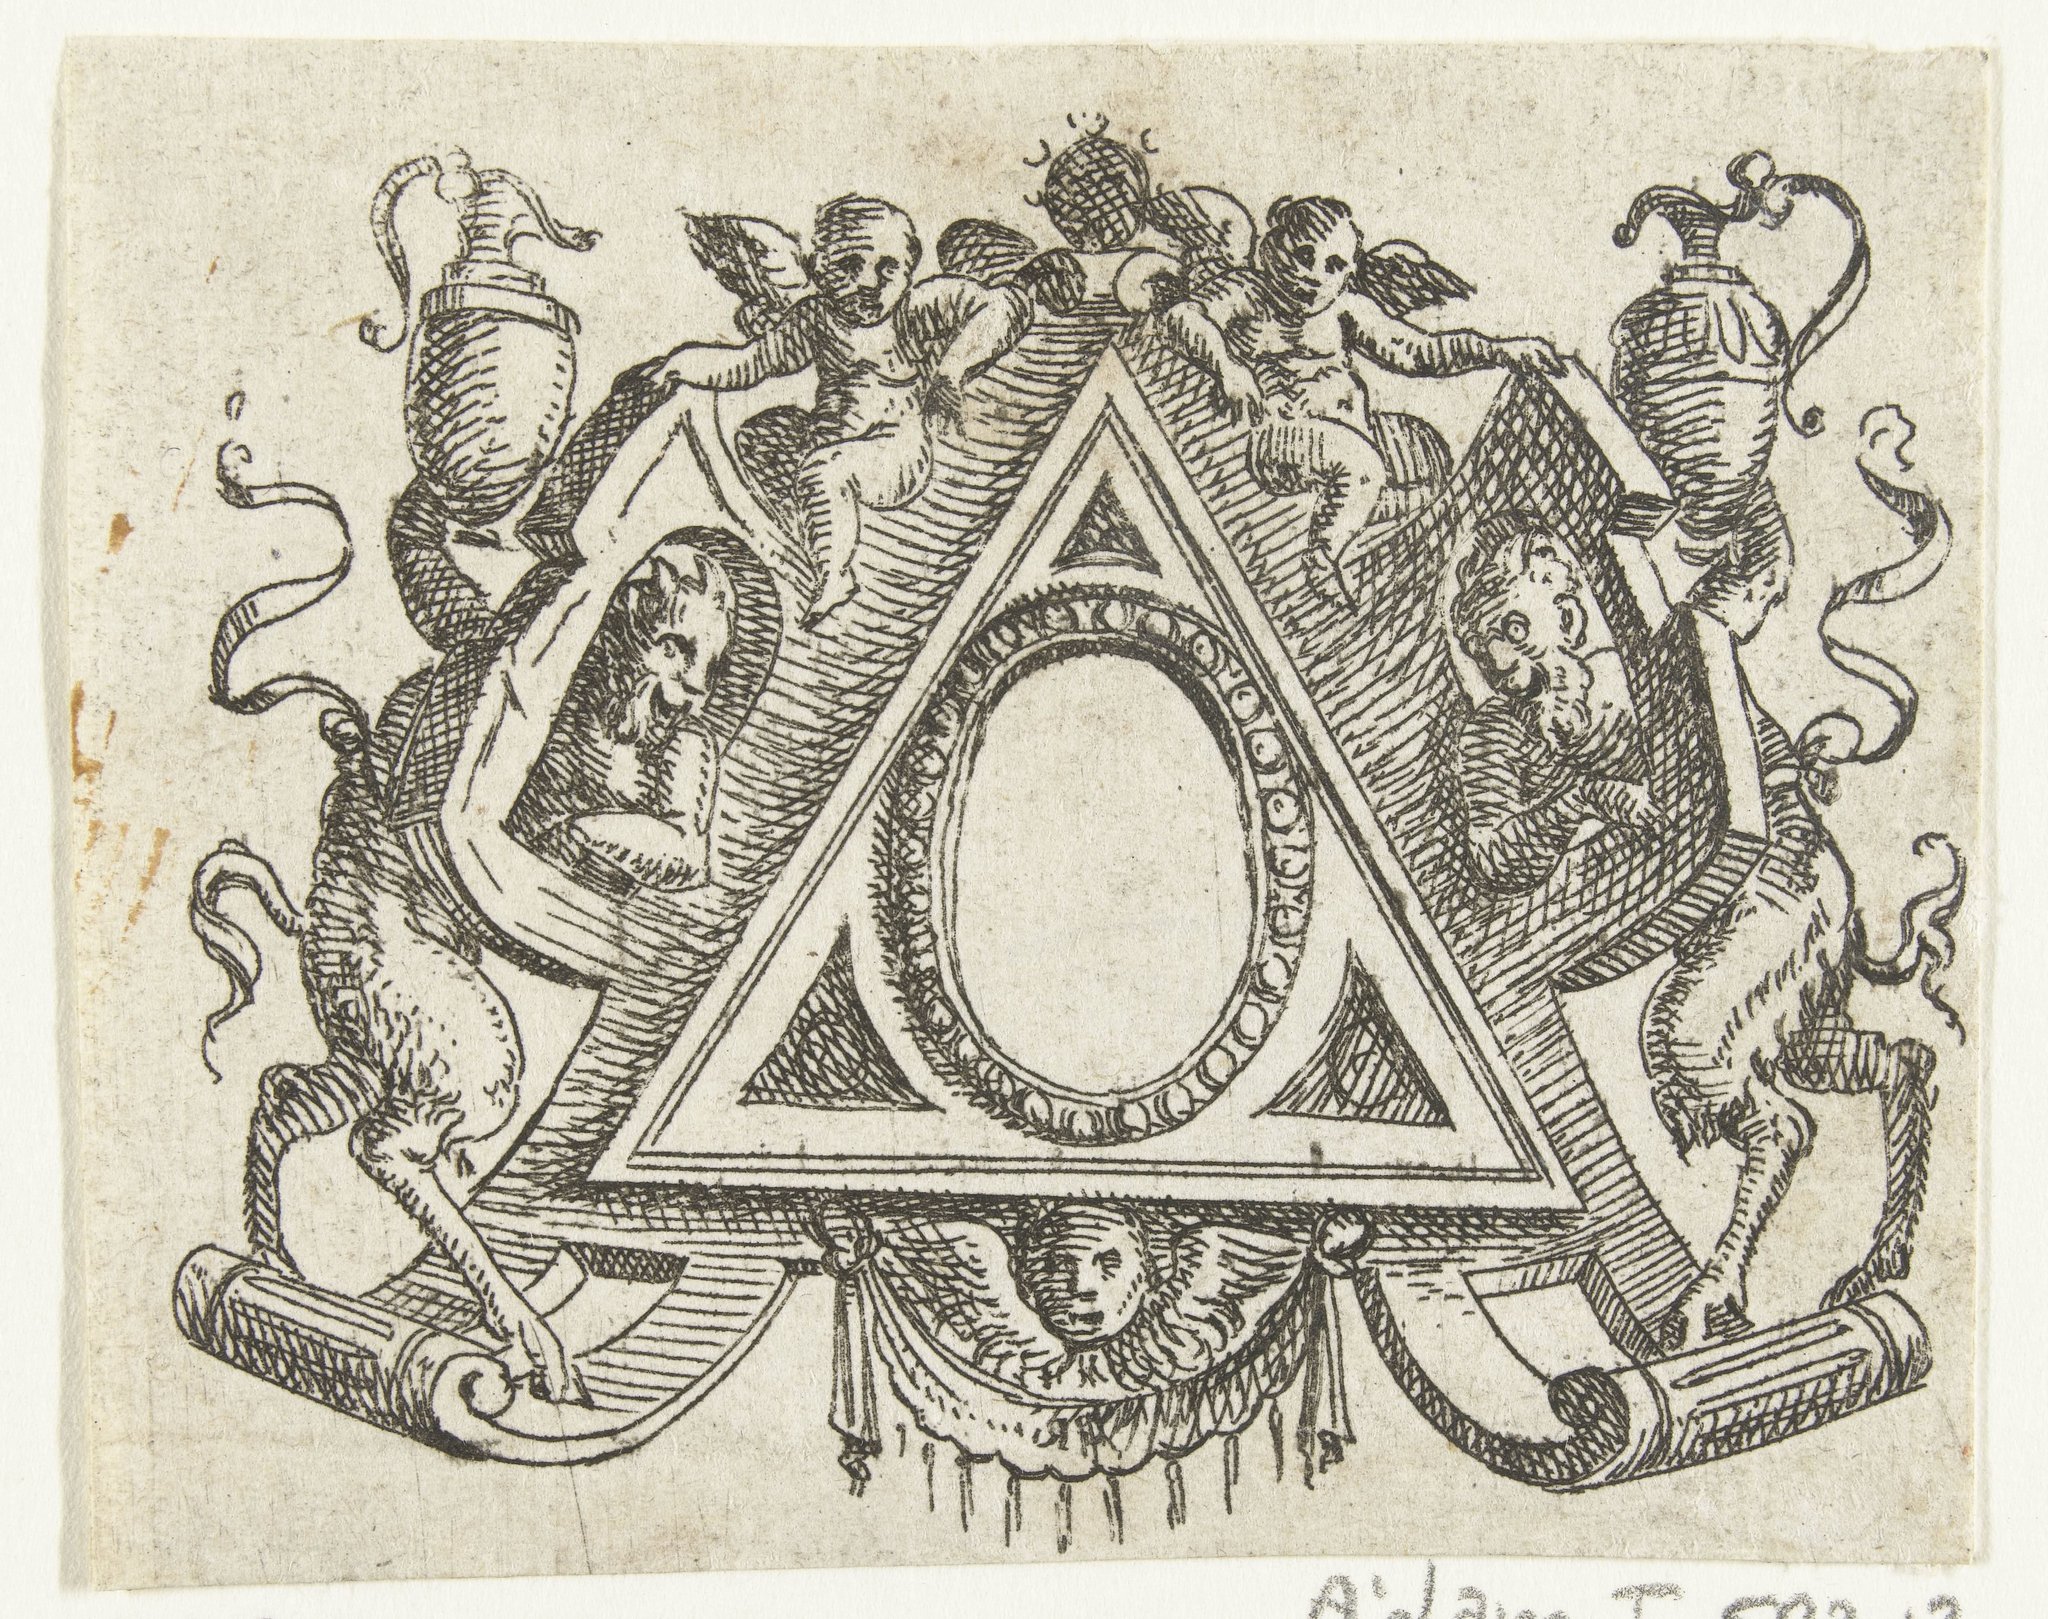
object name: ornament print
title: Ovale cartouche in een driehoekige omlijsting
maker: Anonymous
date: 1500-1600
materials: paper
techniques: etching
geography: france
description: Uit serie van 17 bladen. Links en rechts staat een sater met een vaas in zijn hand.